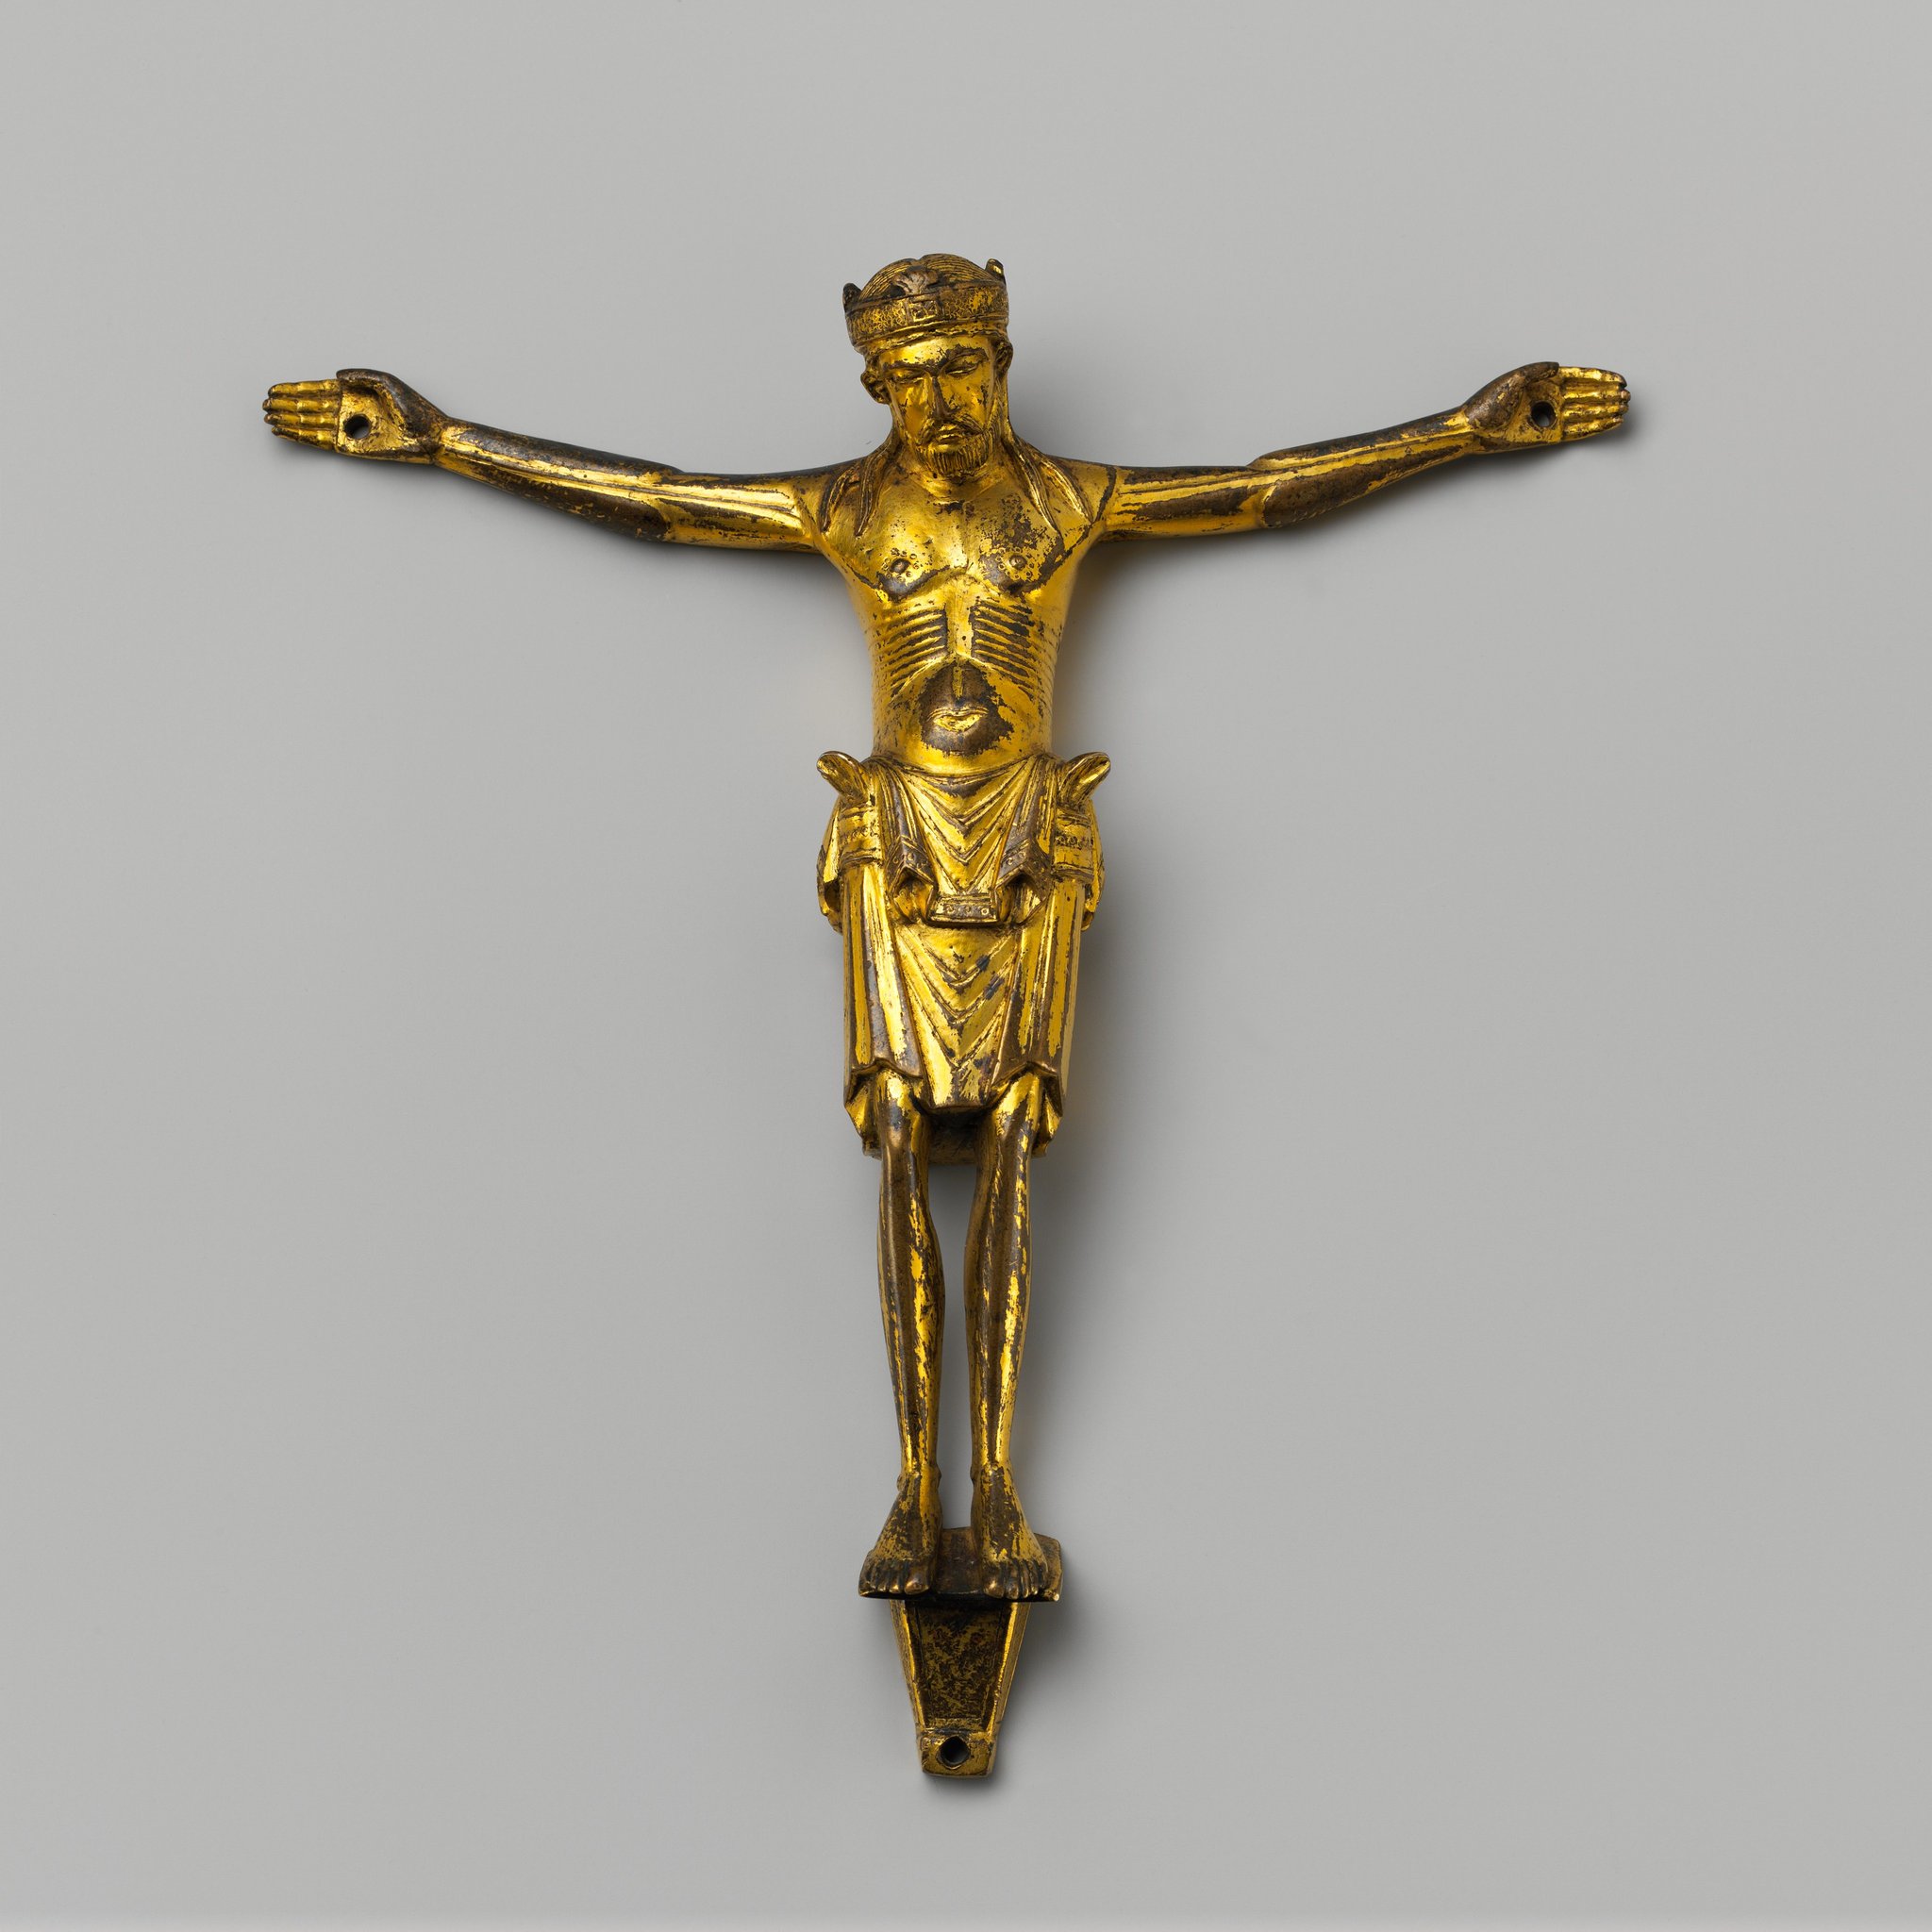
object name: corpus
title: Crucified Christ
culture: french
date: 1150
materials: copper alloy, gilt